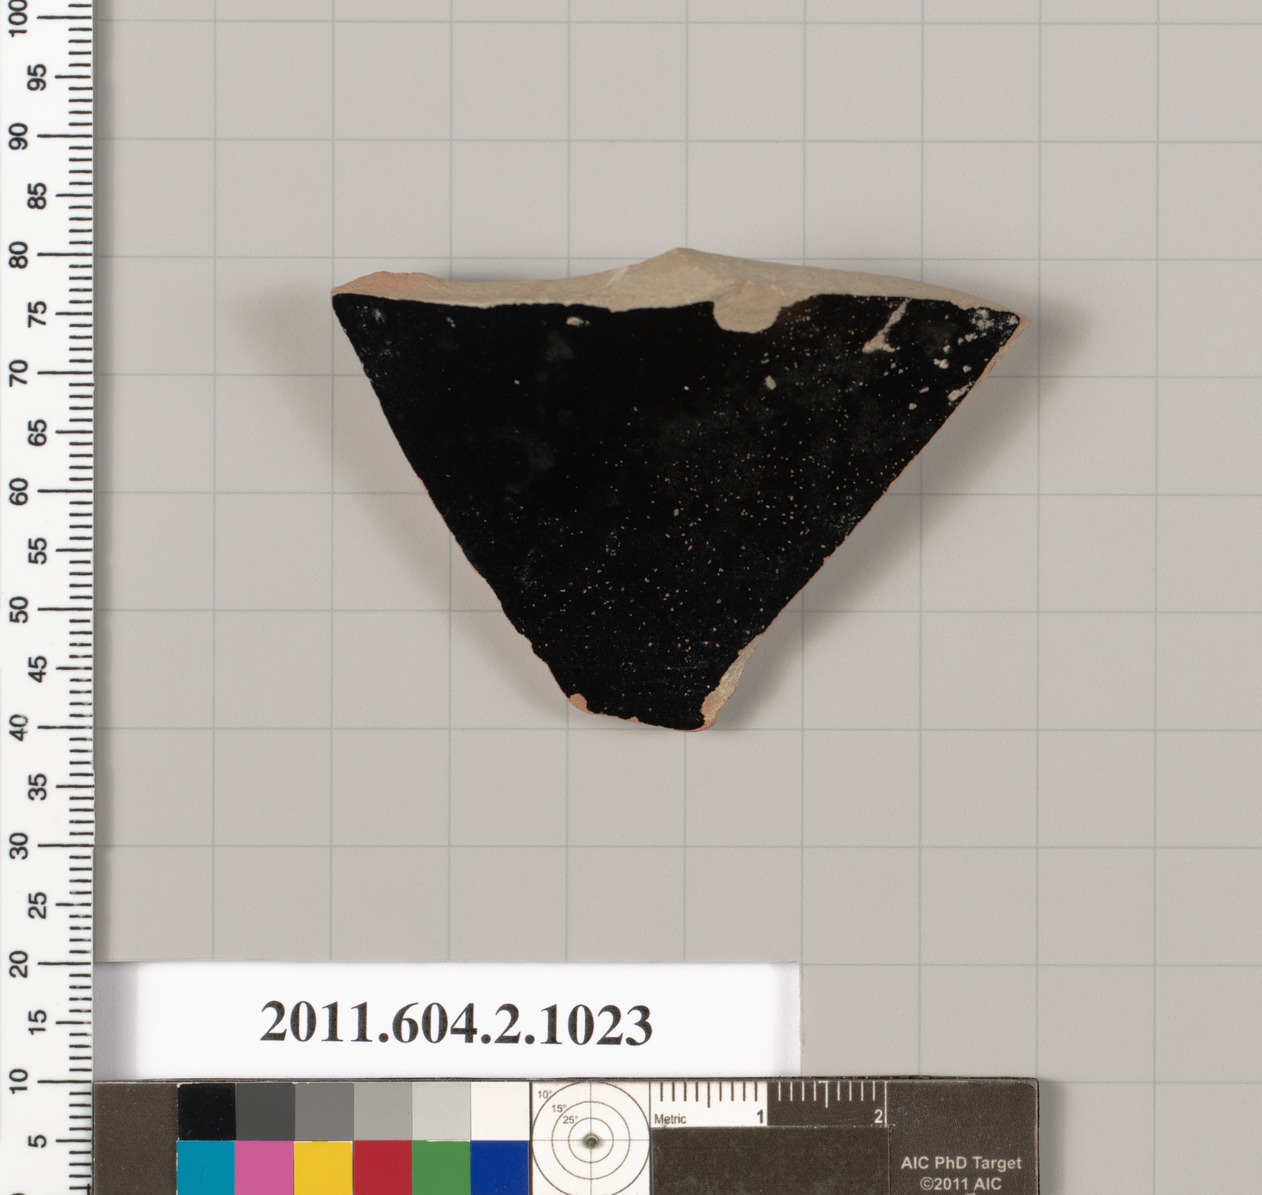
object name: oinochoe fragment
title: Terracotta fragment of an oinochoe (jug)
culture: greek, attic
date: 475-425 BCE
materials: terracotta